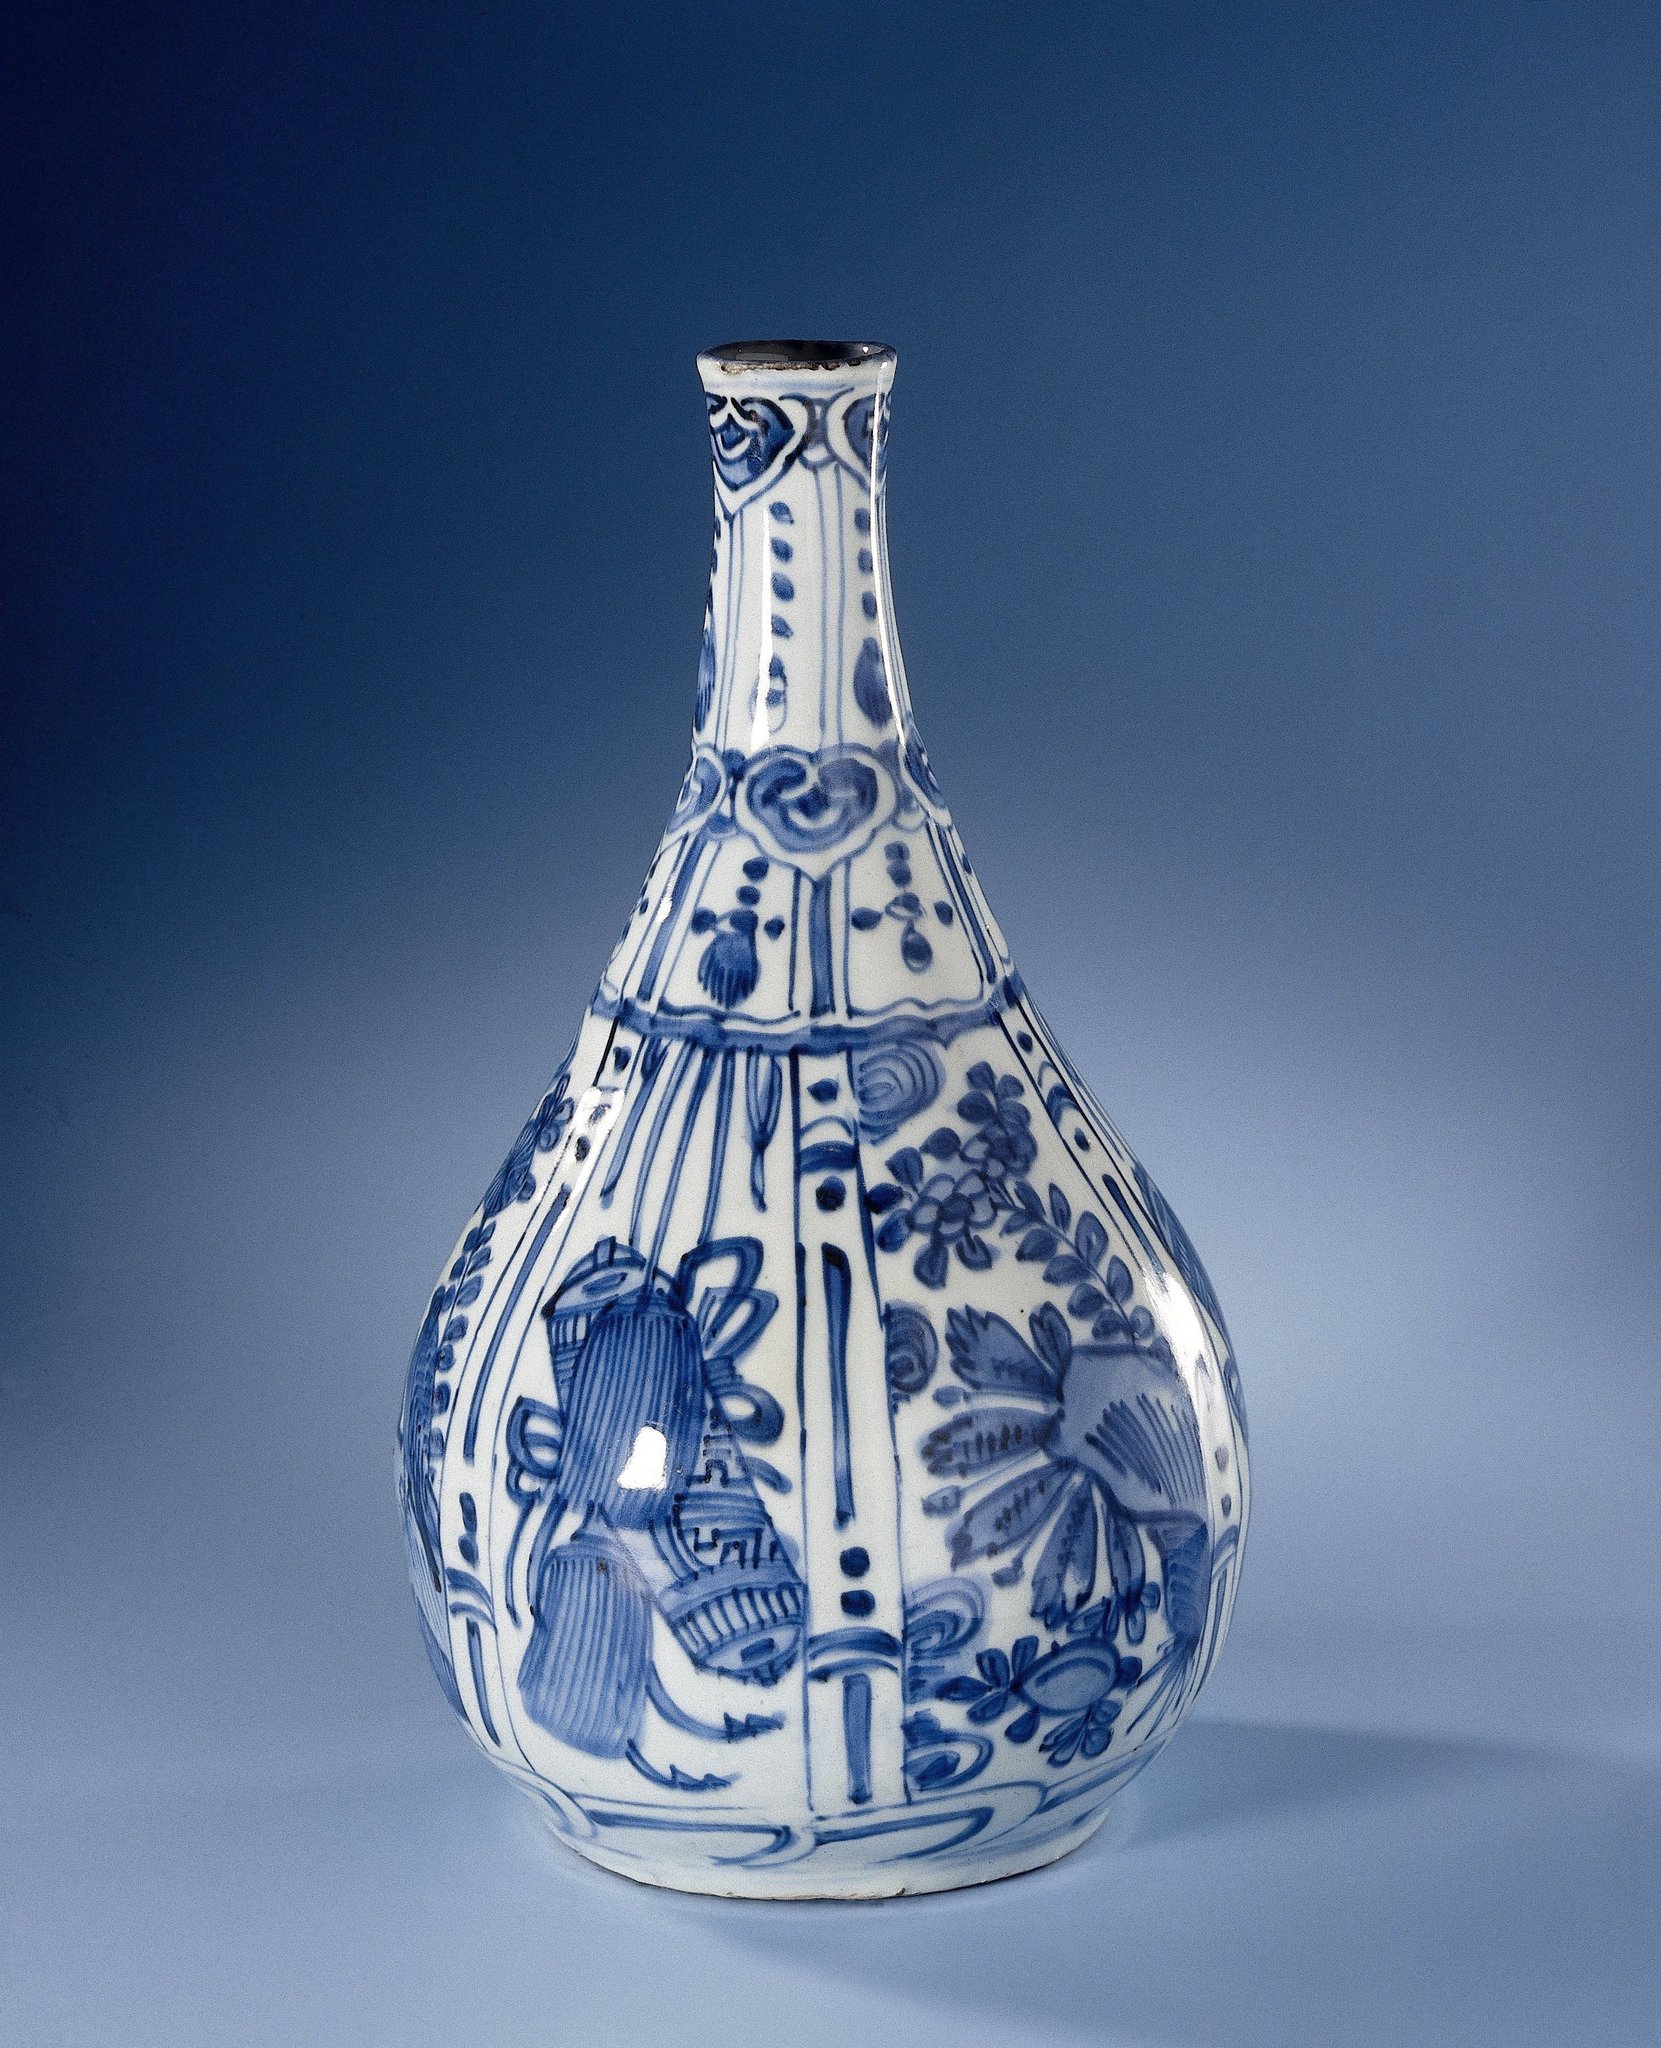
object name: bottle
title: Pear-shaped bottle vase with flowering plants and auspicious objects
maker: Anonymous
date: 1600-1649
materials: cobalt, glaze, paint, porcelain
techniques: firing, turning, vitrification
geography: china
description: Flesvormige vaas van porselein met een peervormig lichaam en een iets spreidende hals, beschilderd in onderglazuur blauw. De buitenwand is op de buik gemodelleerd in brede en smalle, rechthoekige vakken. In de brede vakken afwisselend een bloeiende plant op een rot of kwasten met een gelukssymbool (kalebas, rol); de smalle vakken met strepen en stippen. Op de hals smalle, rechthoekige vakken met kralenhangers met kwasten. De vakken worden onderbroken door een band met ruyi-motieven. Op de buitenrand een band met ruyi-motieven. Rond de voet een decoratieve band. Kraakporselein in blauw-wit.